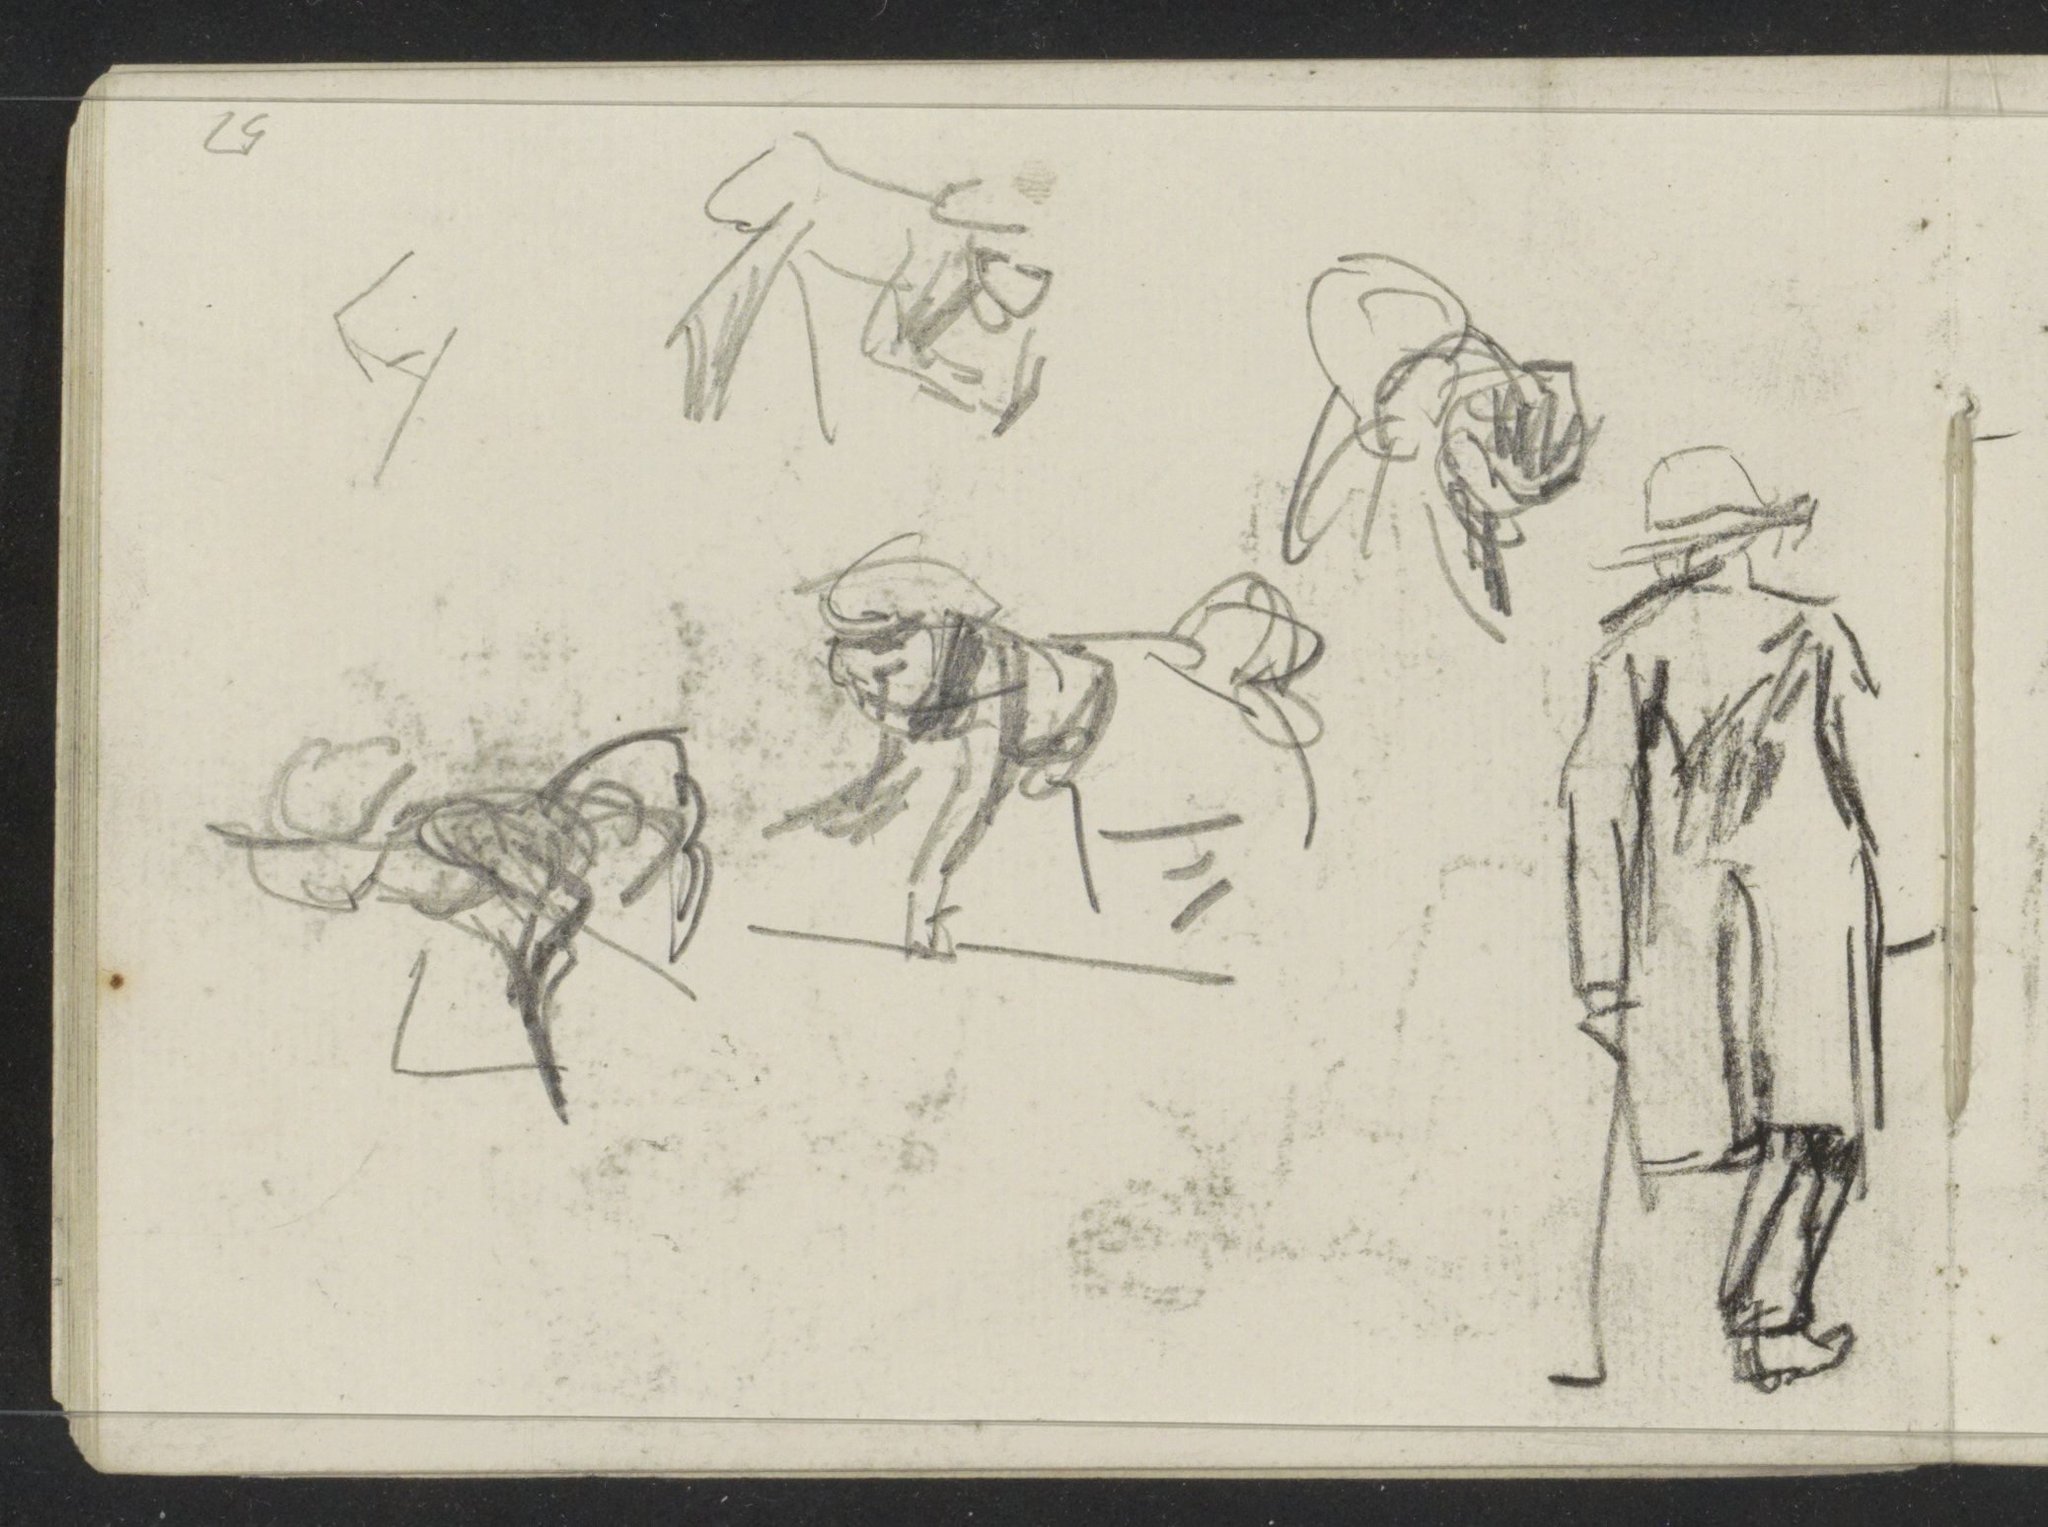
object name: sketchbook leaf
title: Figuurstudies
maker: isaac israels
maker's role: draughtsman, painter, print maker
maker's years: 1865-1934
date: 1886-1934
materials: chalk, paper, pencil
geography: amsterdam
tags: bending figure - aa - female human figure, adult man (+ standing)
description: Onder andere een bukkende vrouw en een staande man. Blad 8 verso uit schetsboek LXIV met 29 bladen.